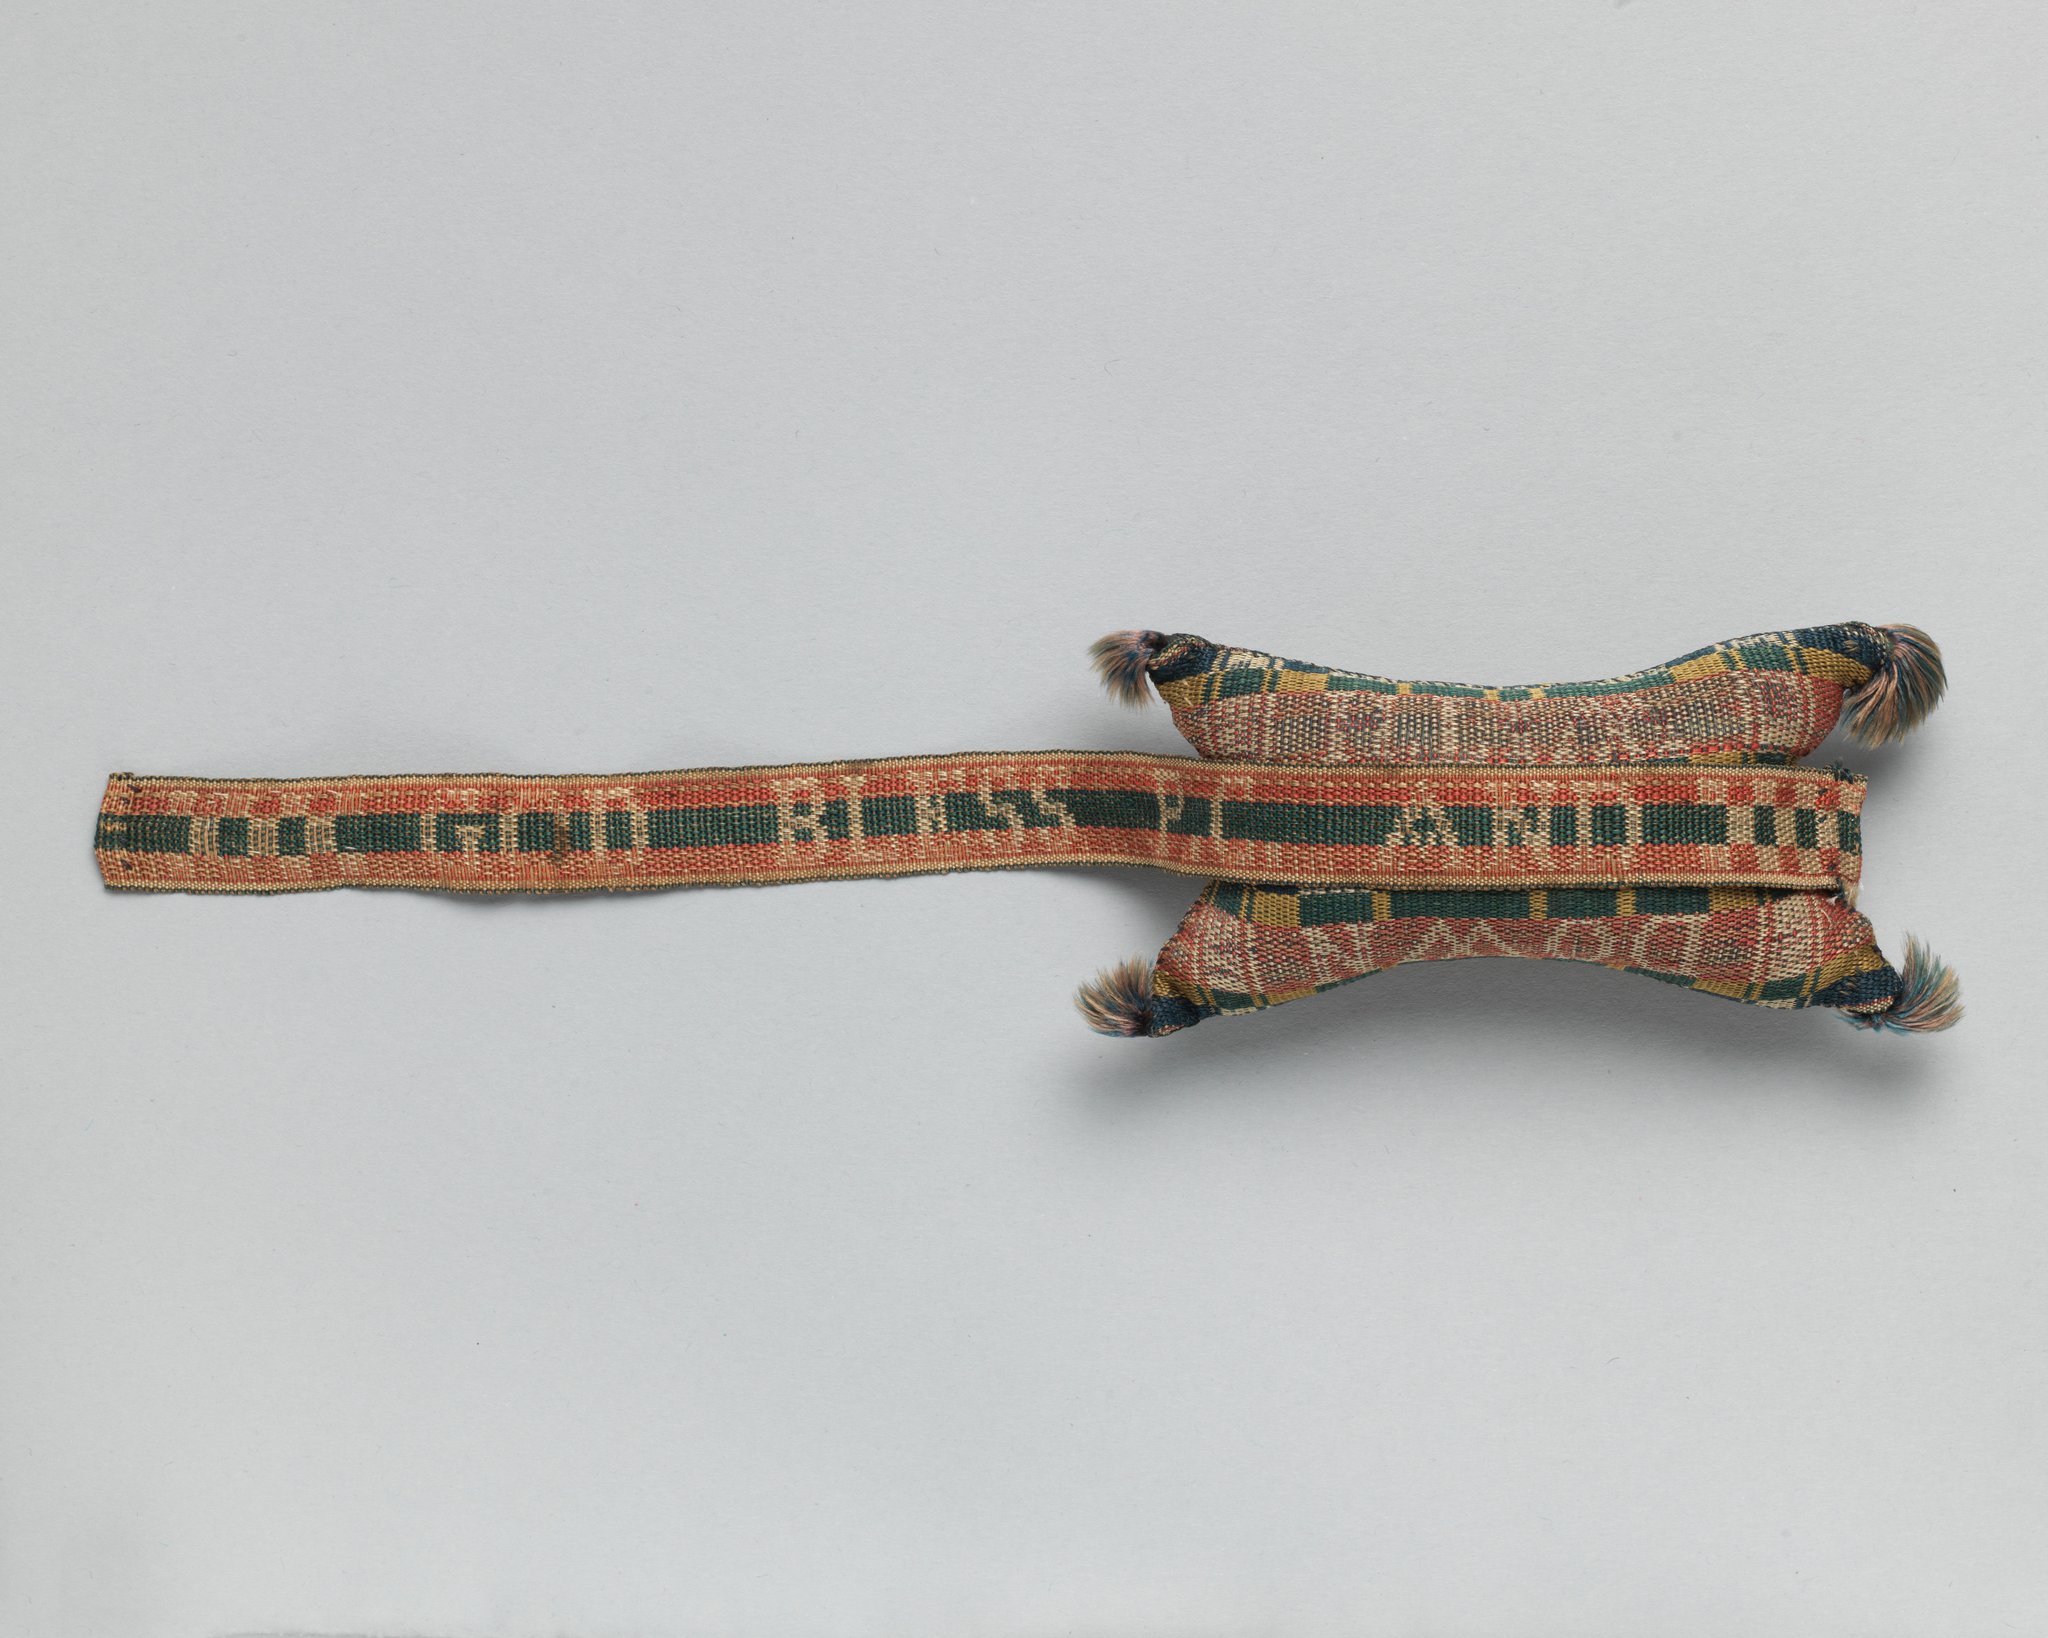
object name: pincushion and ribbon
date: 1745-1750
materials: silk